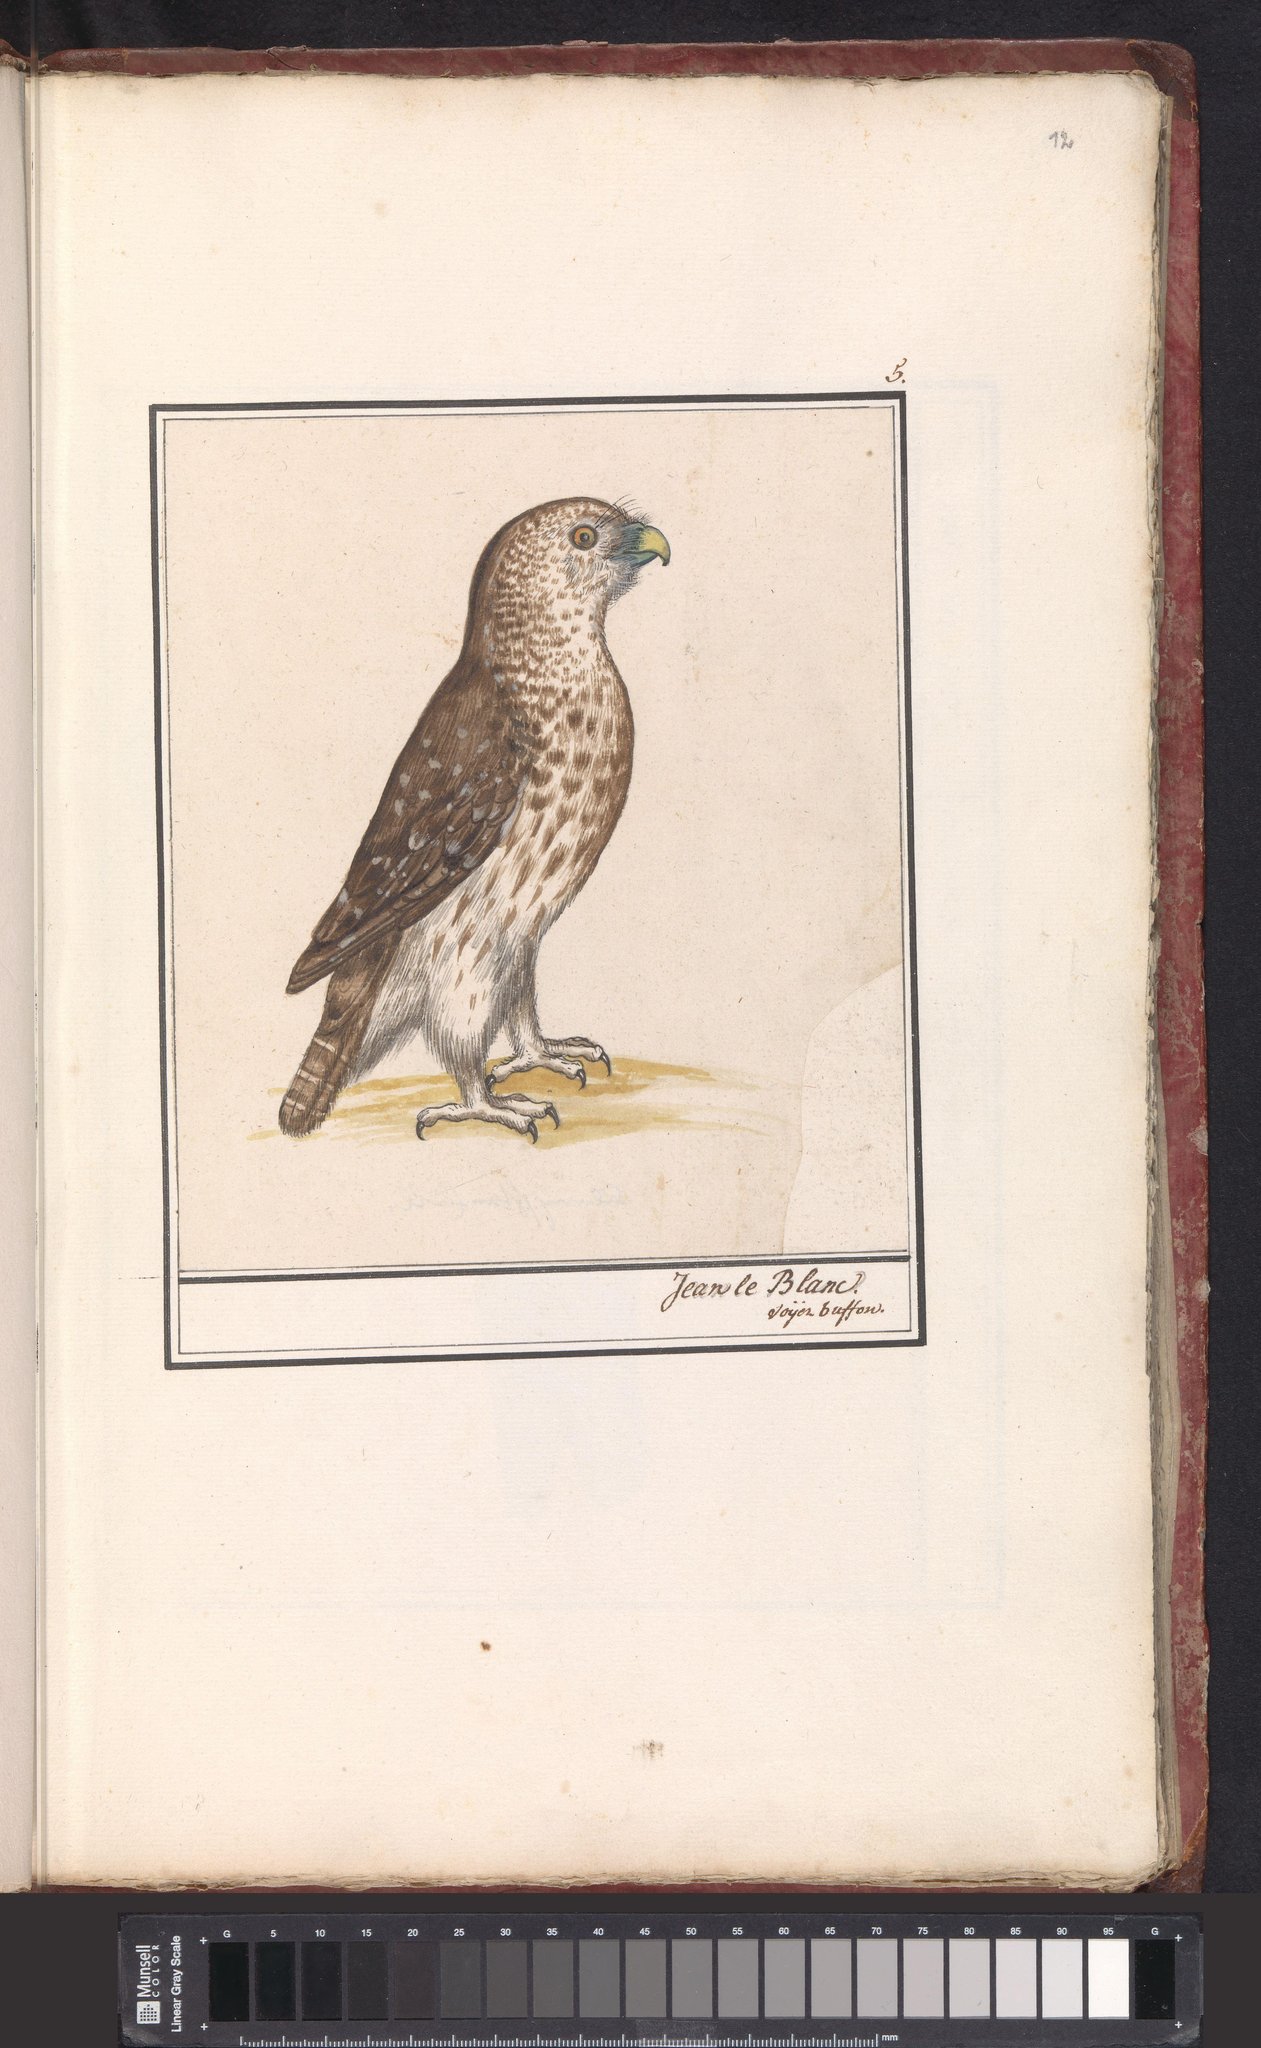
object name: drawing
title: Slangenarend (Circaetus gallicus)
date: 1596-1610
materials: paint, paper, watercolor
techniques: brush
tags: predatory birds: eagle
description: Slangenarend. Genummerd rechtsboven: 5. Onderdeel van het eerste album met tekeningen van vogels. Derde van twaalf albums met tekeningen van dieren, vogels en planten bekend rond 1600, gemaakt in opdracht van keizer Rudolf II. Met toelichting in Nederlands, Latijn en Frans.